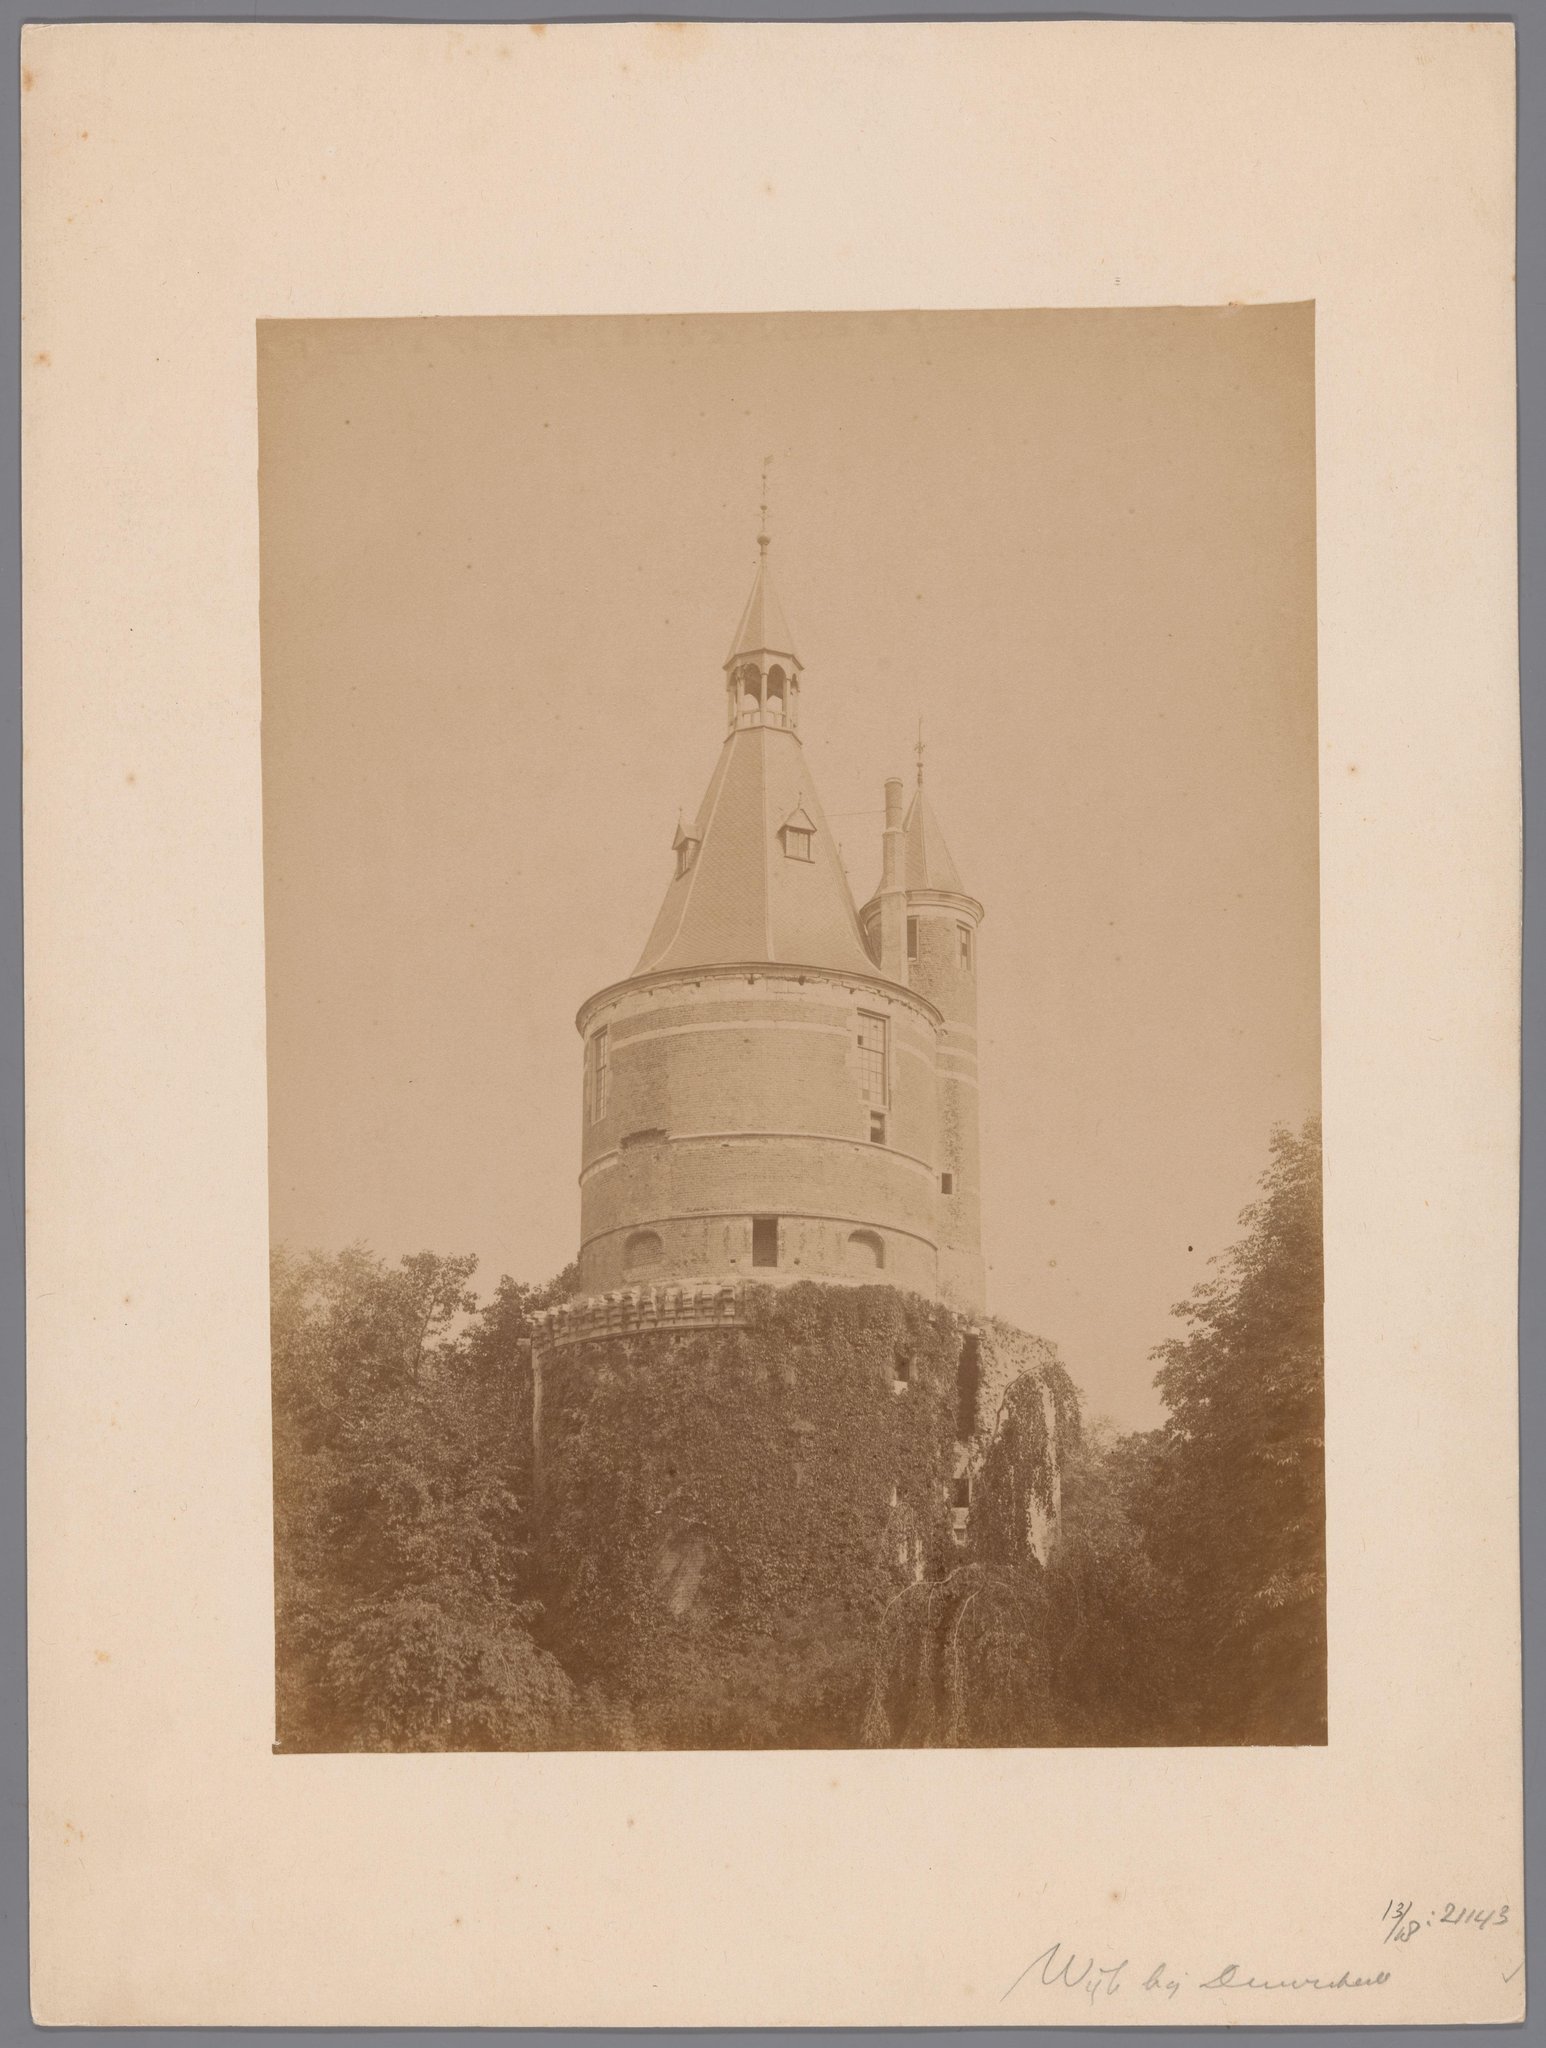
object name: photograph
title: Toren van Kasteel Duurstede te Wijk bij Duurstede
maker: anoniem (monumentenzorg)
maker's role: fotograaf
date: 1892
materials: cardboard, photographic support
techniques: albumen print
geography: wijk bij duurstede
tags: ruin of a dwelling, house, castle, etc.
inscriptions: annotation: ‘Wijk bij Duurstede 13/18:21143’, annotation: ‘Kasteel te Wijk-bij-Duurstede (U.)/ sept 1892’